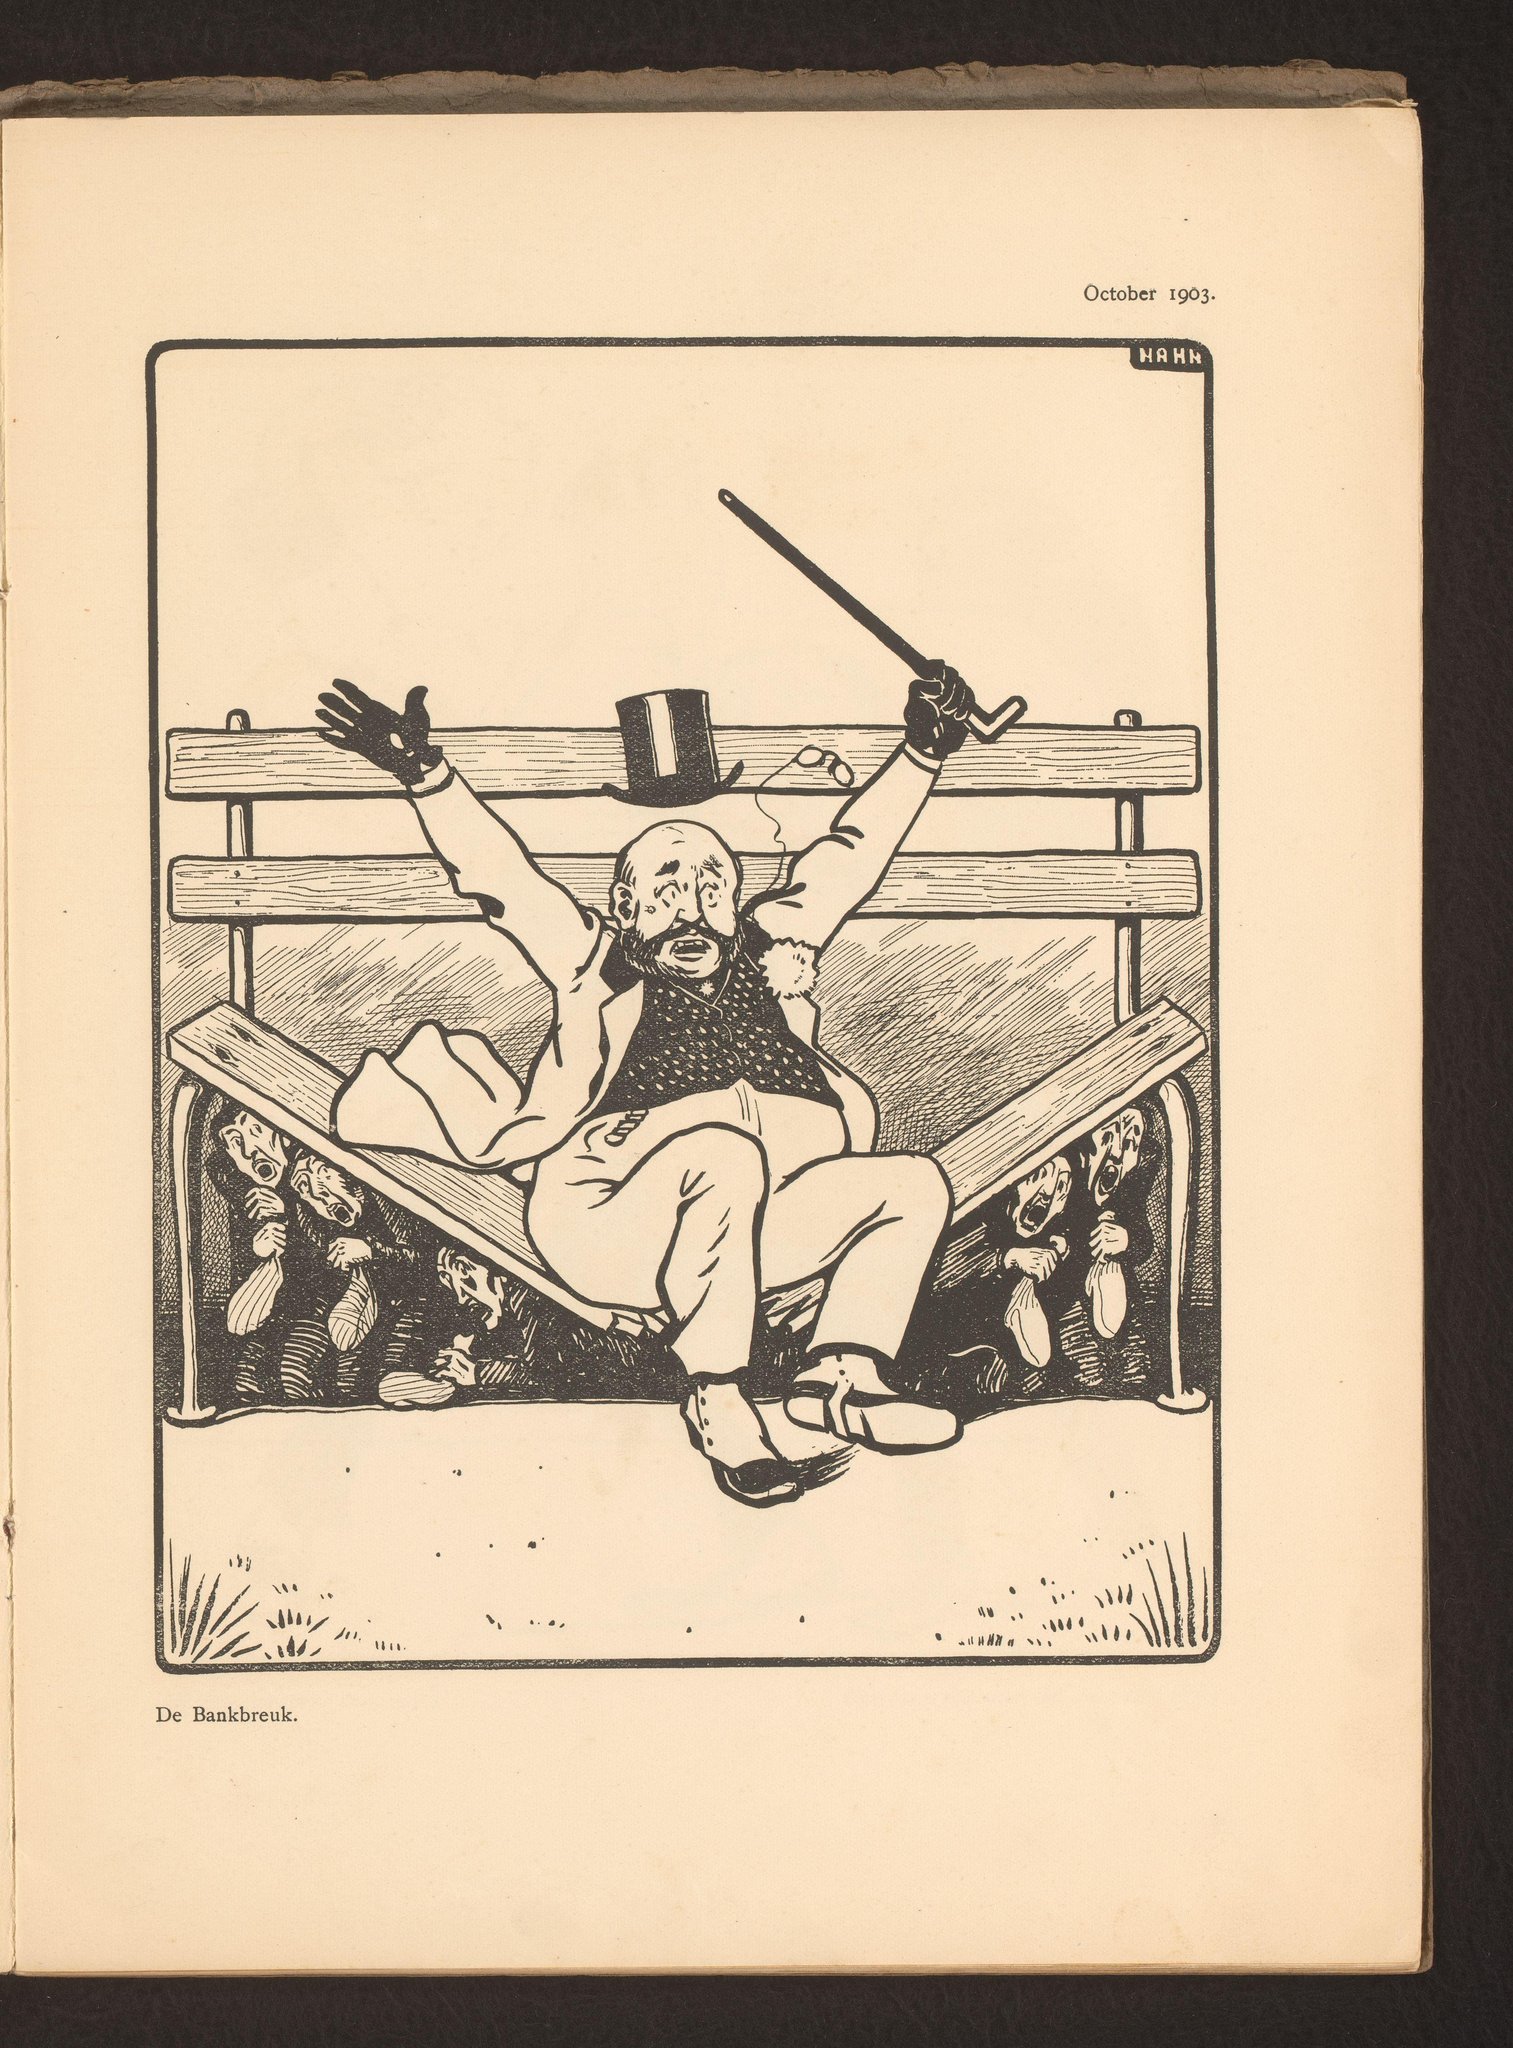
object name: photomechanical print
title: De Bankbreuk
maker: albert hahn (i)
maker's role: draughtsman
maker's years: 1877-1918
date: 1903-1910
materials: paper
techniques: autotype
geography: netherlands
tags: bankruptcy, banker, the rich, working class, labourers, the poor, political caricatures and satires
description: Een gezette bankier zakt door een houten zitbank en verplettert een groep mensen die onder de bank schuilen met loonzakjes in hun handen, oktober 1903. Onderdeel van het boek 'Albert Hahn Prenten', heruitgave van een selectie politieke prenten uit de periode 1902-1906.